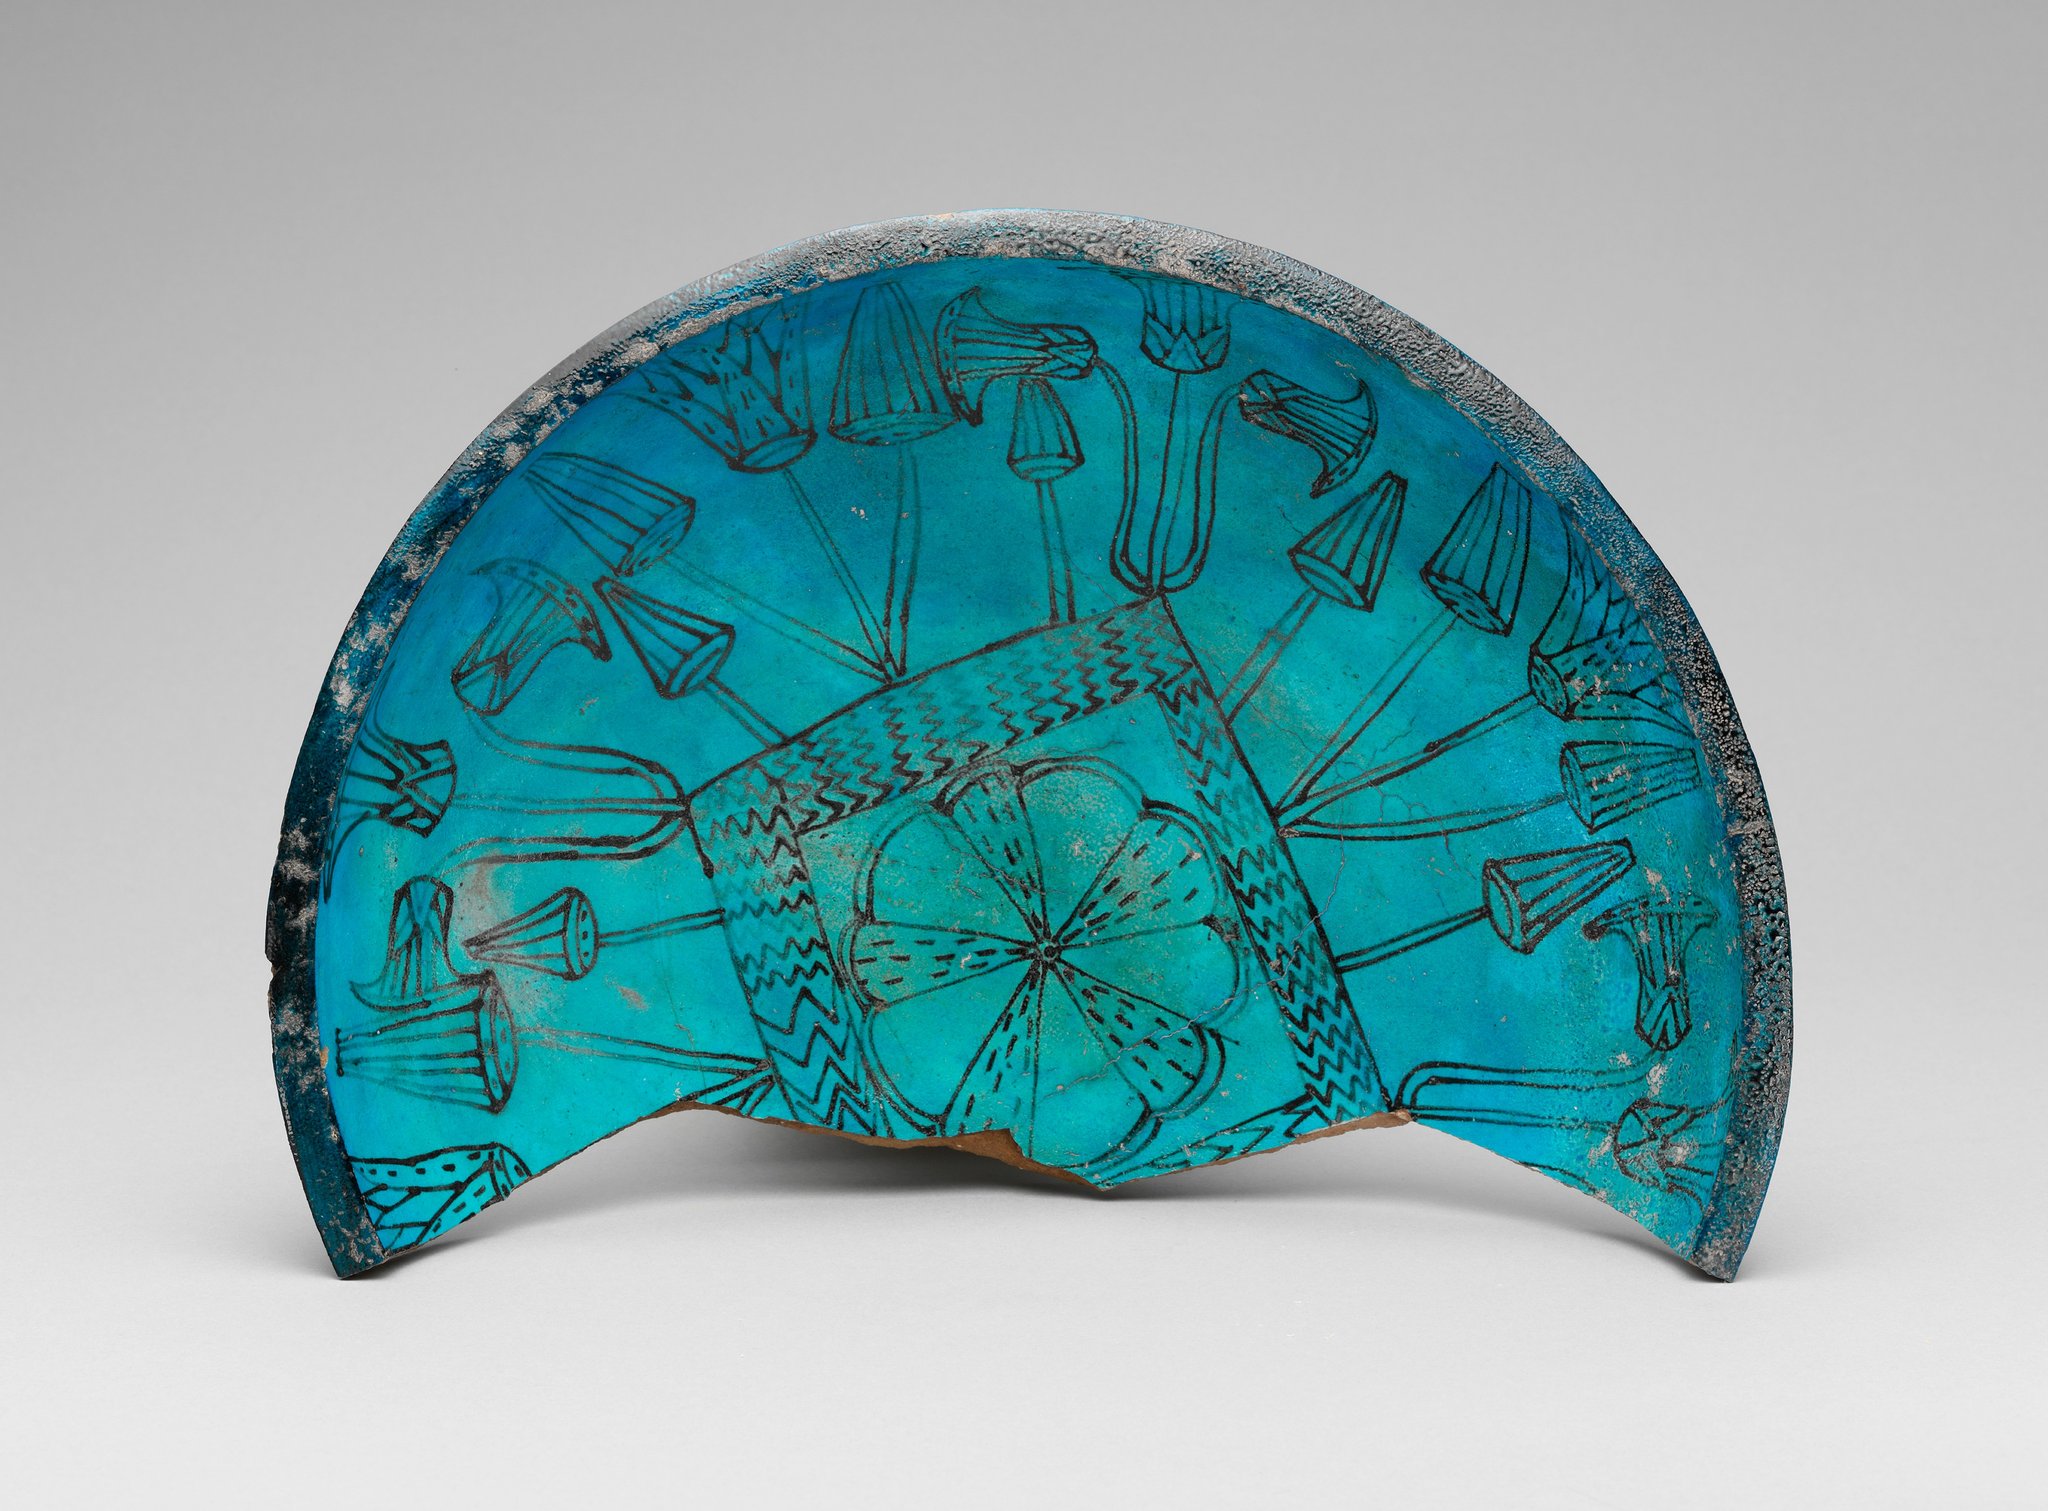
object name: bowl, nun, marsh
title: Marsh Bowl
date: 1479-1458 BCE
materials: faience, paint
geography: egypt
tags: lotuses